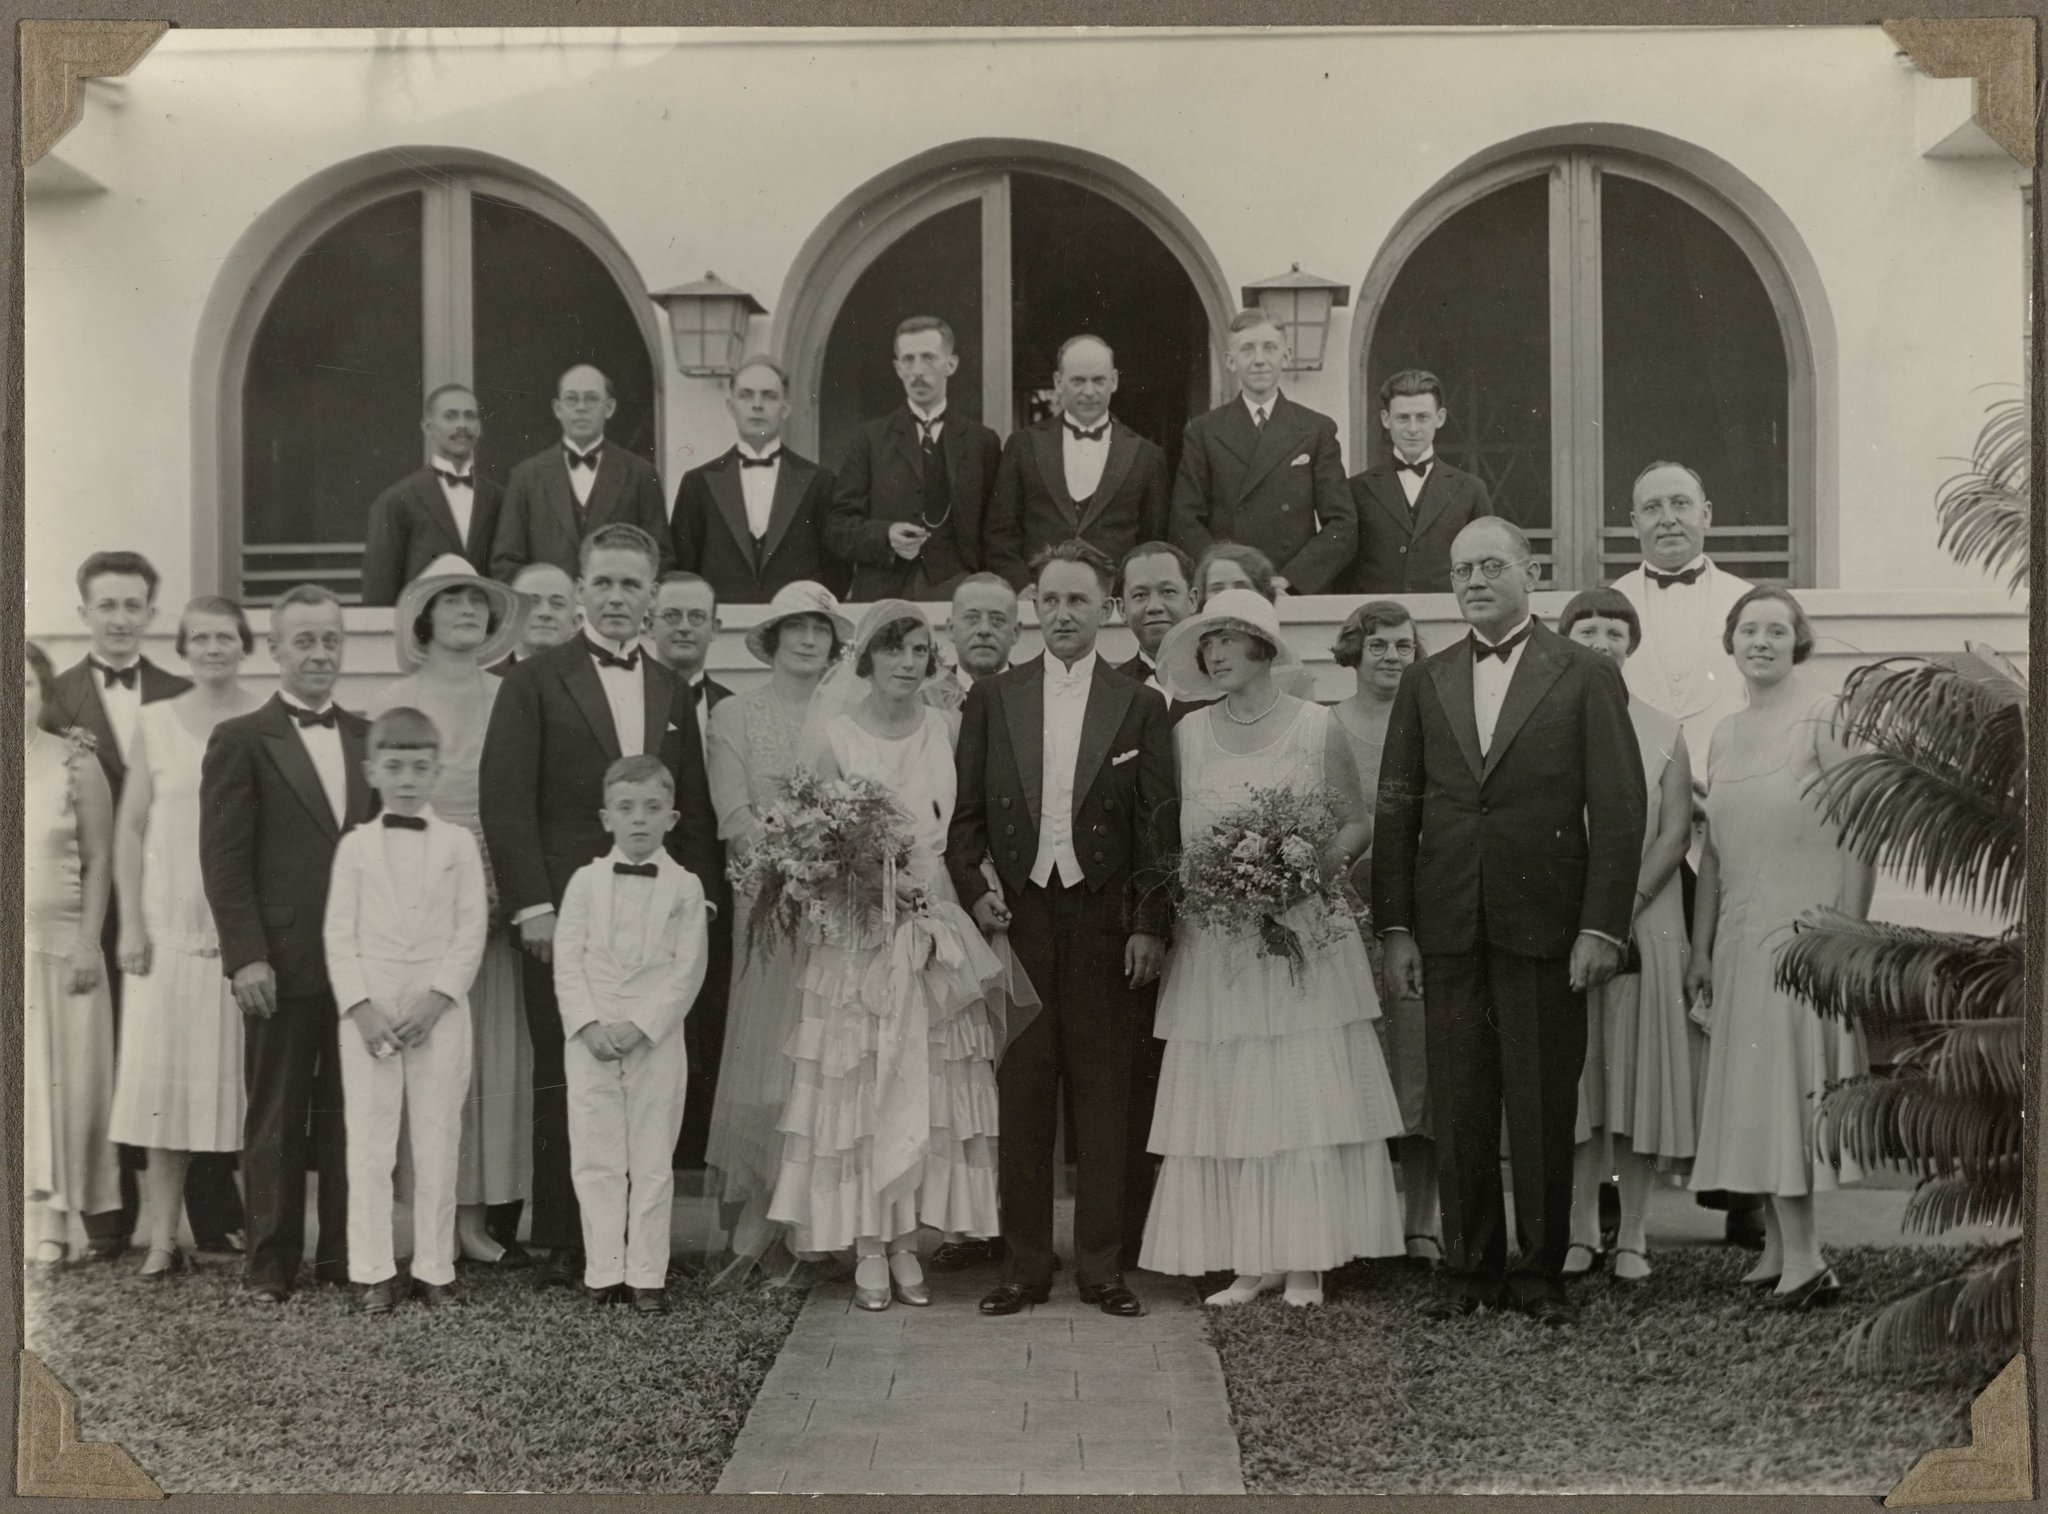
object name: photograph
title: Bruiloft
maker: Anonymous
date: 1925-1927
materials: photographic support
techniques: photography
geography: suriname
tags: (civil) marriage ceremonies, anonymous historical persons portrayed in a group, in a group-portrait, suriname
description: Groepsfoto op een bruiloft, tussen de gasten Edith Jetten. Foto met hoekjes bevestigd op een bladzijde van een albumblad in het fotoalbum over de familie Jetten en het leven en werken in de mijnstad Moengo in Suriname rond 1927.